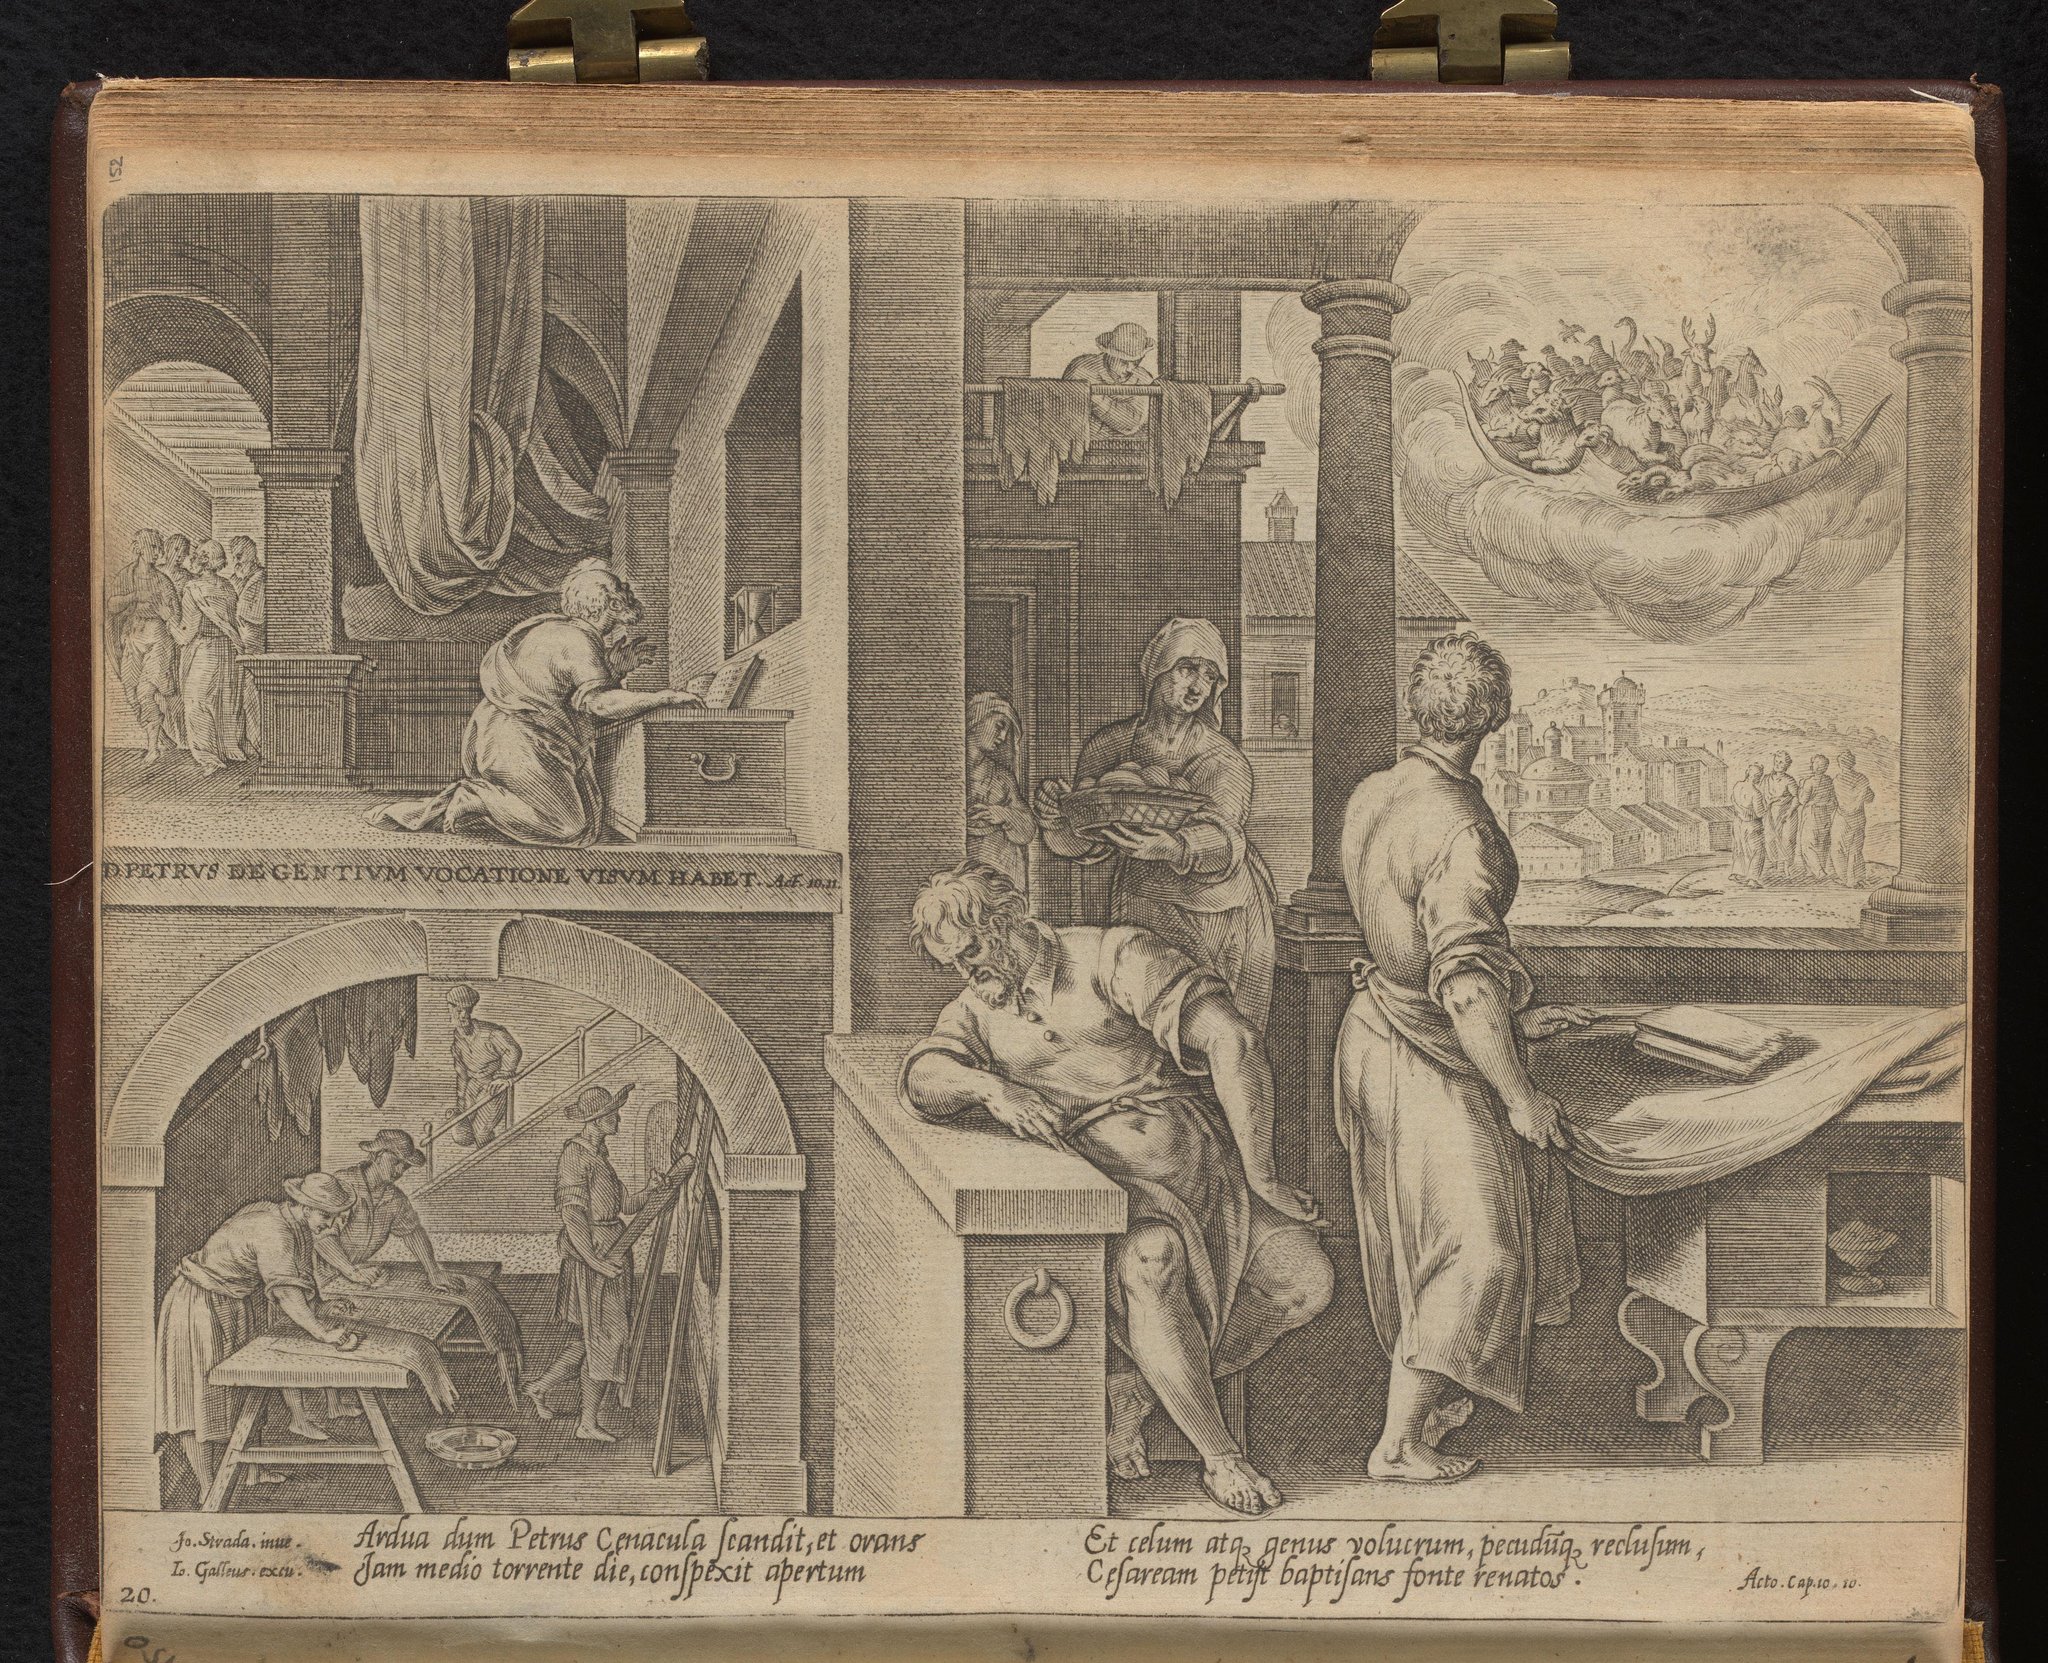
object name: titelprent, frontispice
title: Visioen van de onreine dieren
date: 1582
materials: paper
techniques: engraving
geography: antwerp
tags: peter's vision of the unclean beasts on the roof of the house of simon the tanner: a sheet descends from heaven full of four-footed beasts, creeping things and fowl of the air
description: Prent maakt deel uit van een prentbijbel.